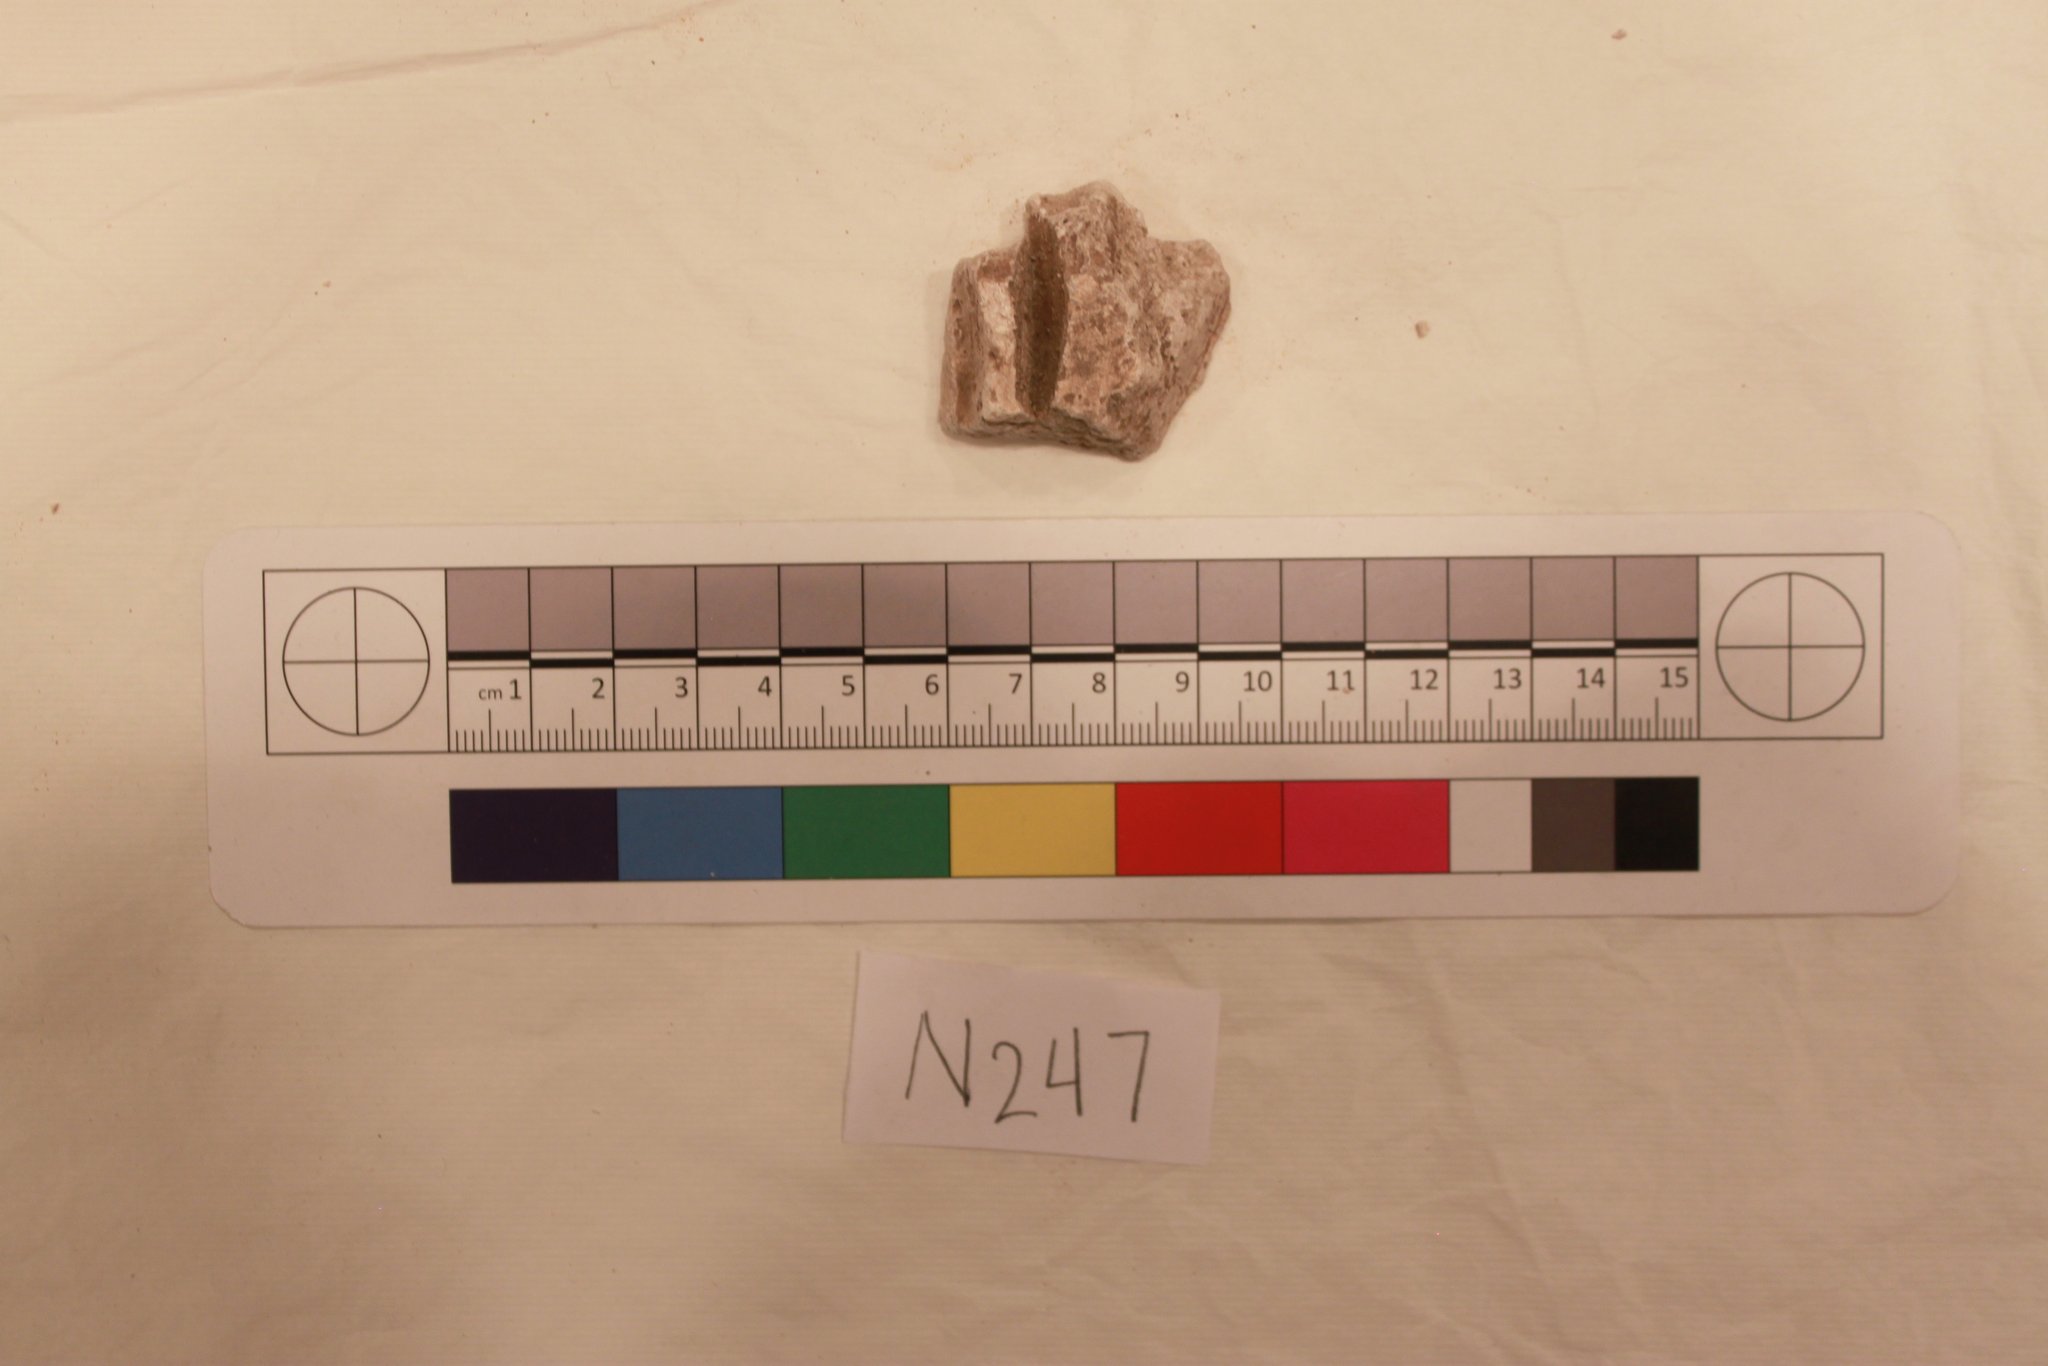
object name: fragment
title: Stucco Fragment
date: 701-1200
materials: plaster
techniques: carving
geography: iran